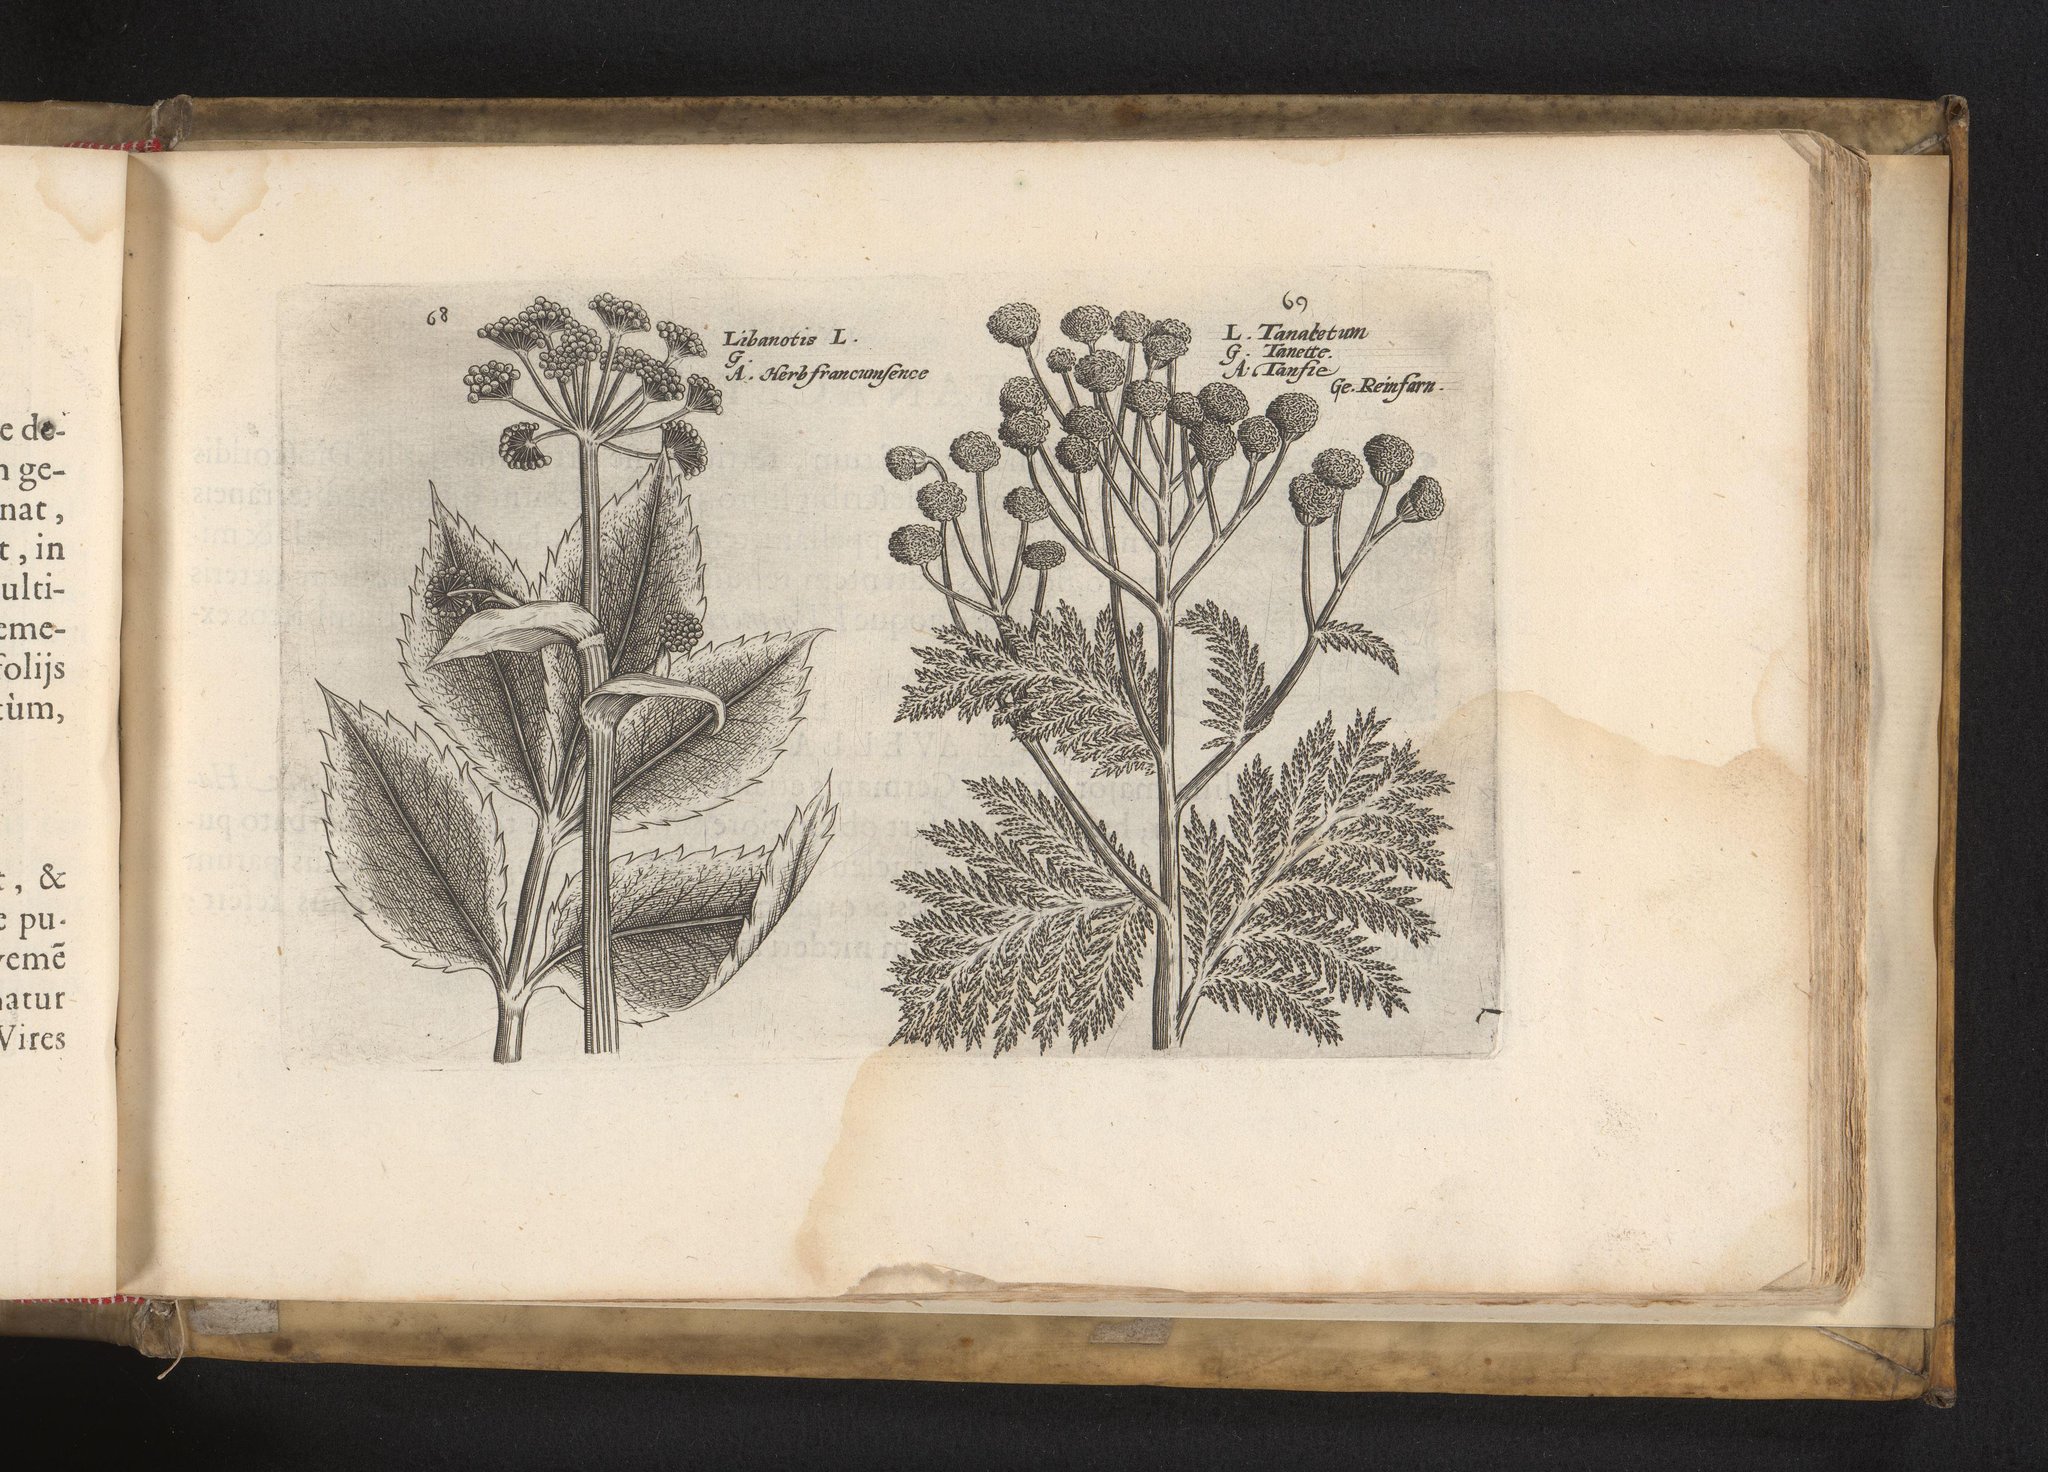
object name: book illustration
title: Libanotis / Herb francumsence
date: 1617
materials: paper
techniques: engraving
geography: arnhem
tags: flowers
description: Prent uit: Passe, Crispijn van de (II). Hortus floridus in quo rariorum & minus vulgarium florum icones ad vivam veramque formam. Arnhem: Johannes Janssonius, 1617.